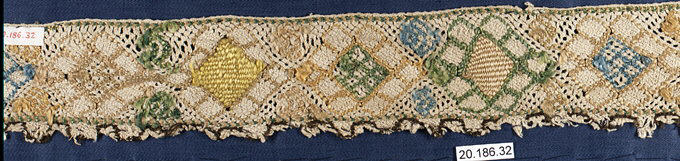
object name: strip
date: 1701-1800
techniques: lace